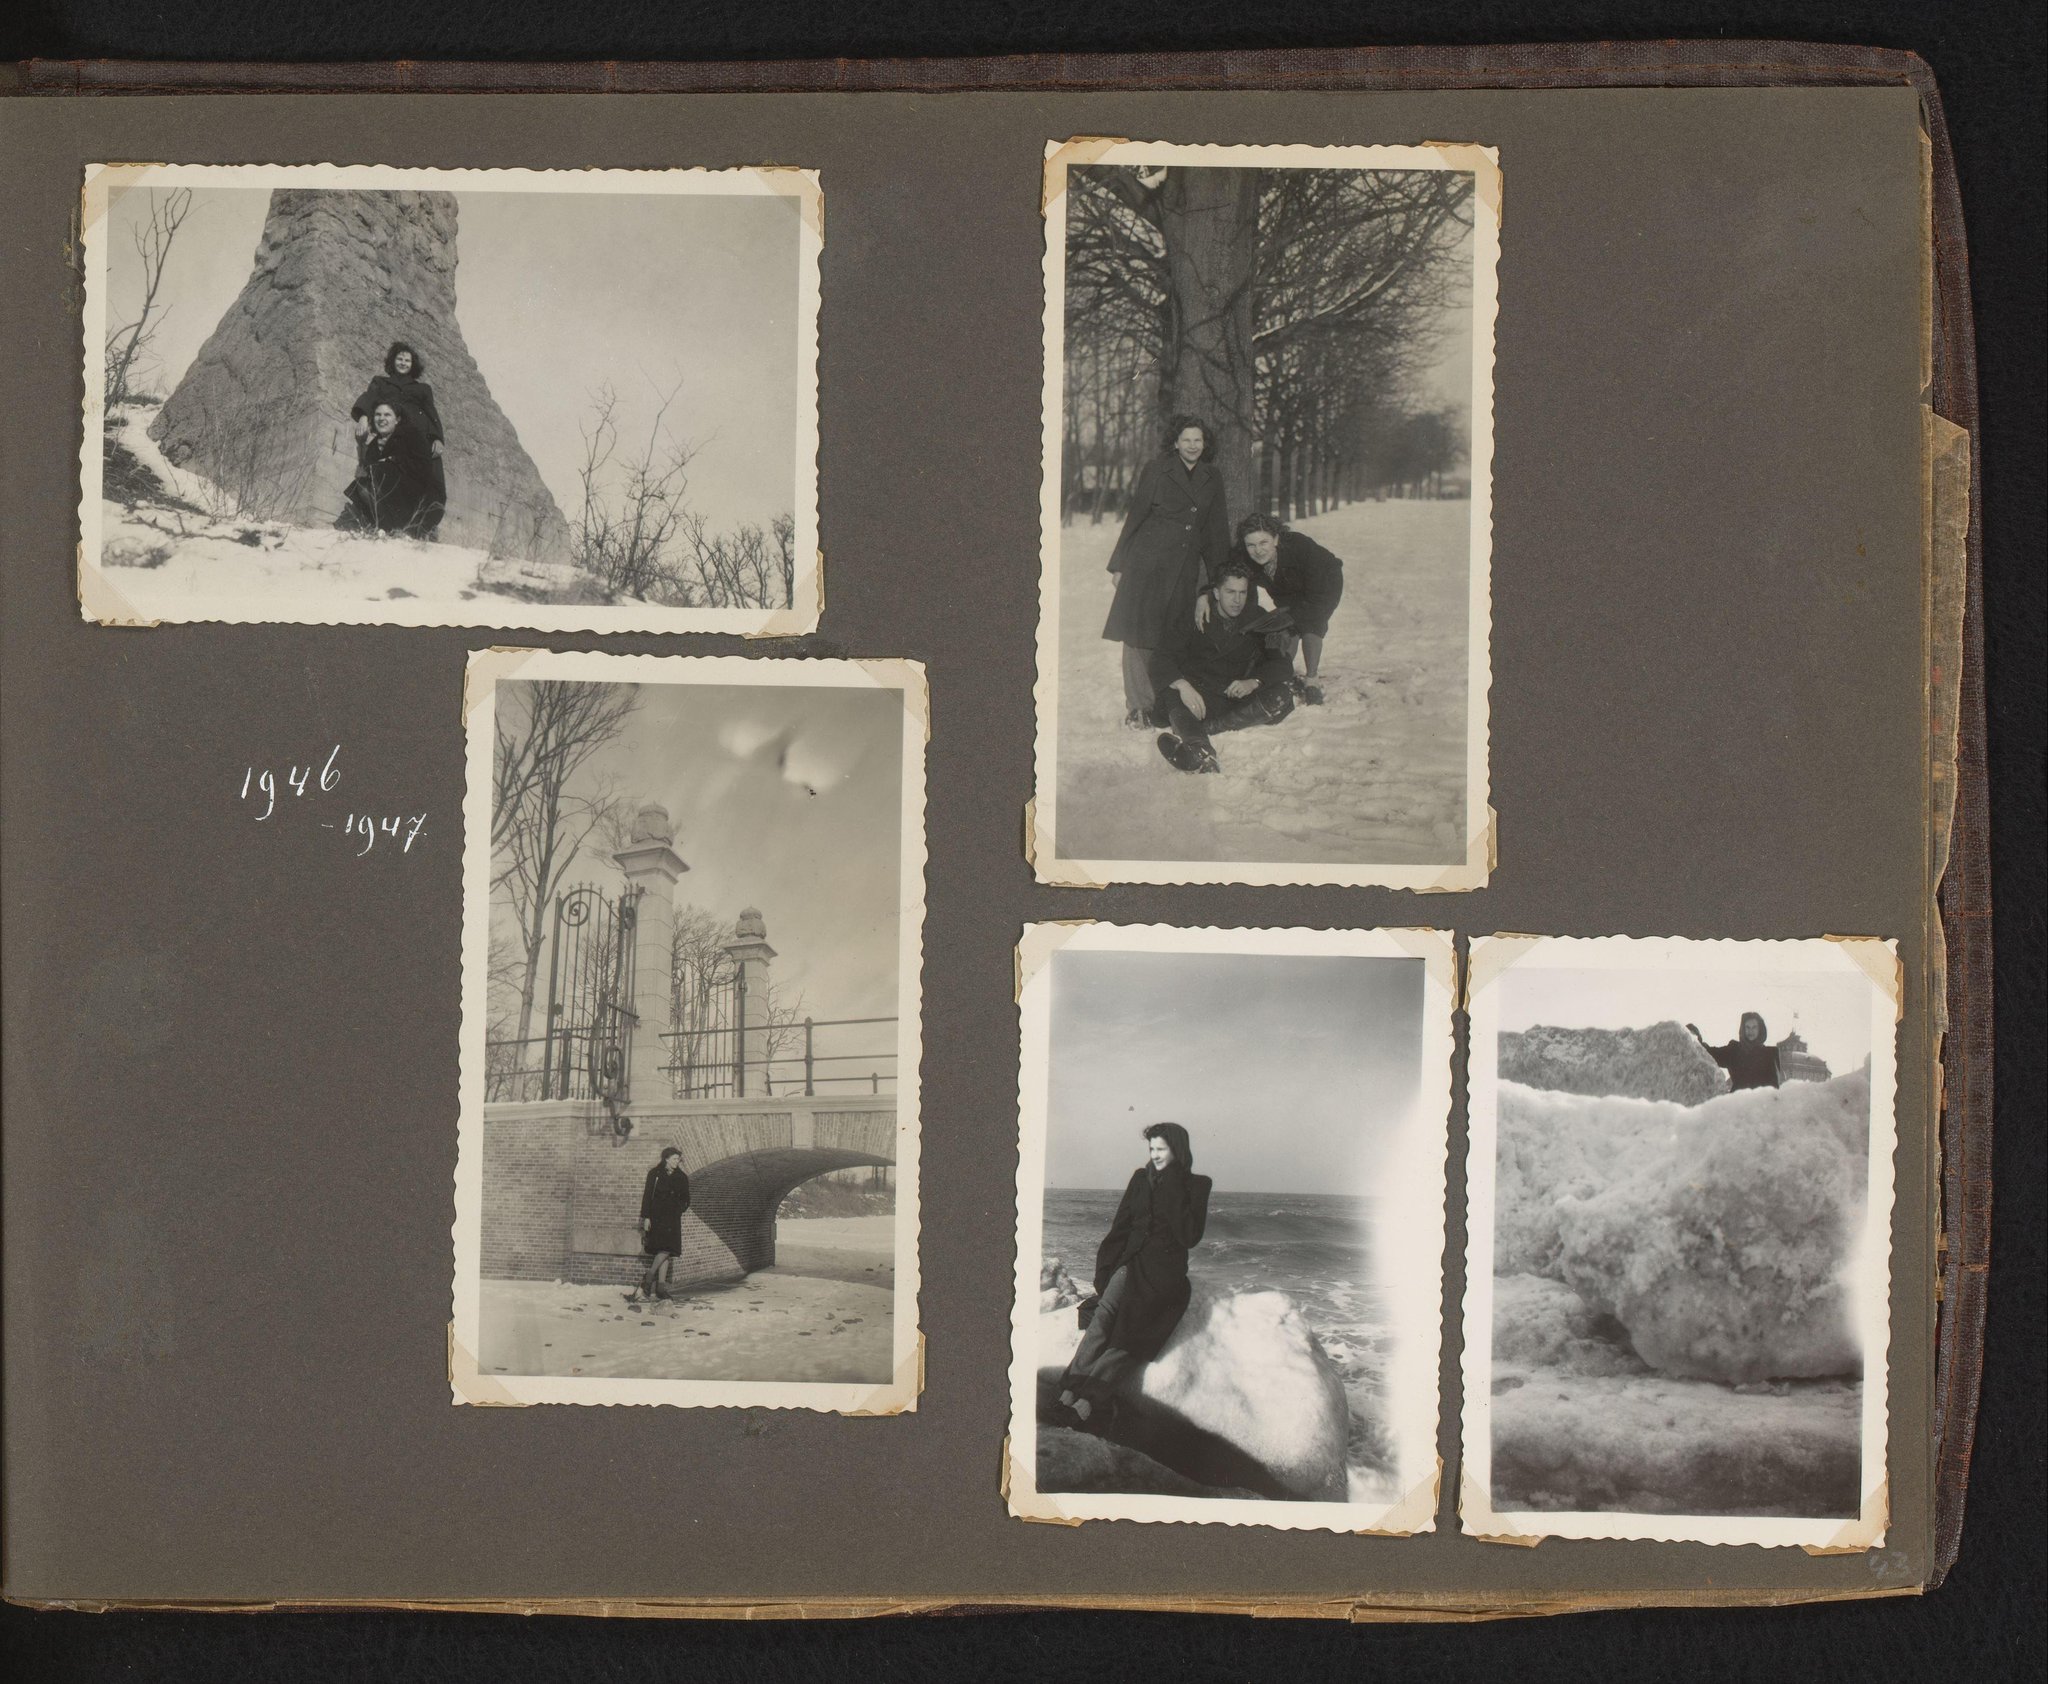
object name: album leaf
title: Winter 1946-1947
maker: Anonymous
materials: paper, photographic support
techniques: gelatin silver print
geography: netherlands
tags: enjoying nature, playing with snow and ice - cc - adult(s) ~ snow and ice, open-air recreation, severe winters, netherlands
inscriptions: inscription: ‘1946-1947’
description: Albumblad met vijf foto's van een vriend en vriendin in de natuur met sneeuw en ijs tijdens de strenge winter van 1946-1947. Onderdeel van het Familiealbum 1940-1947.